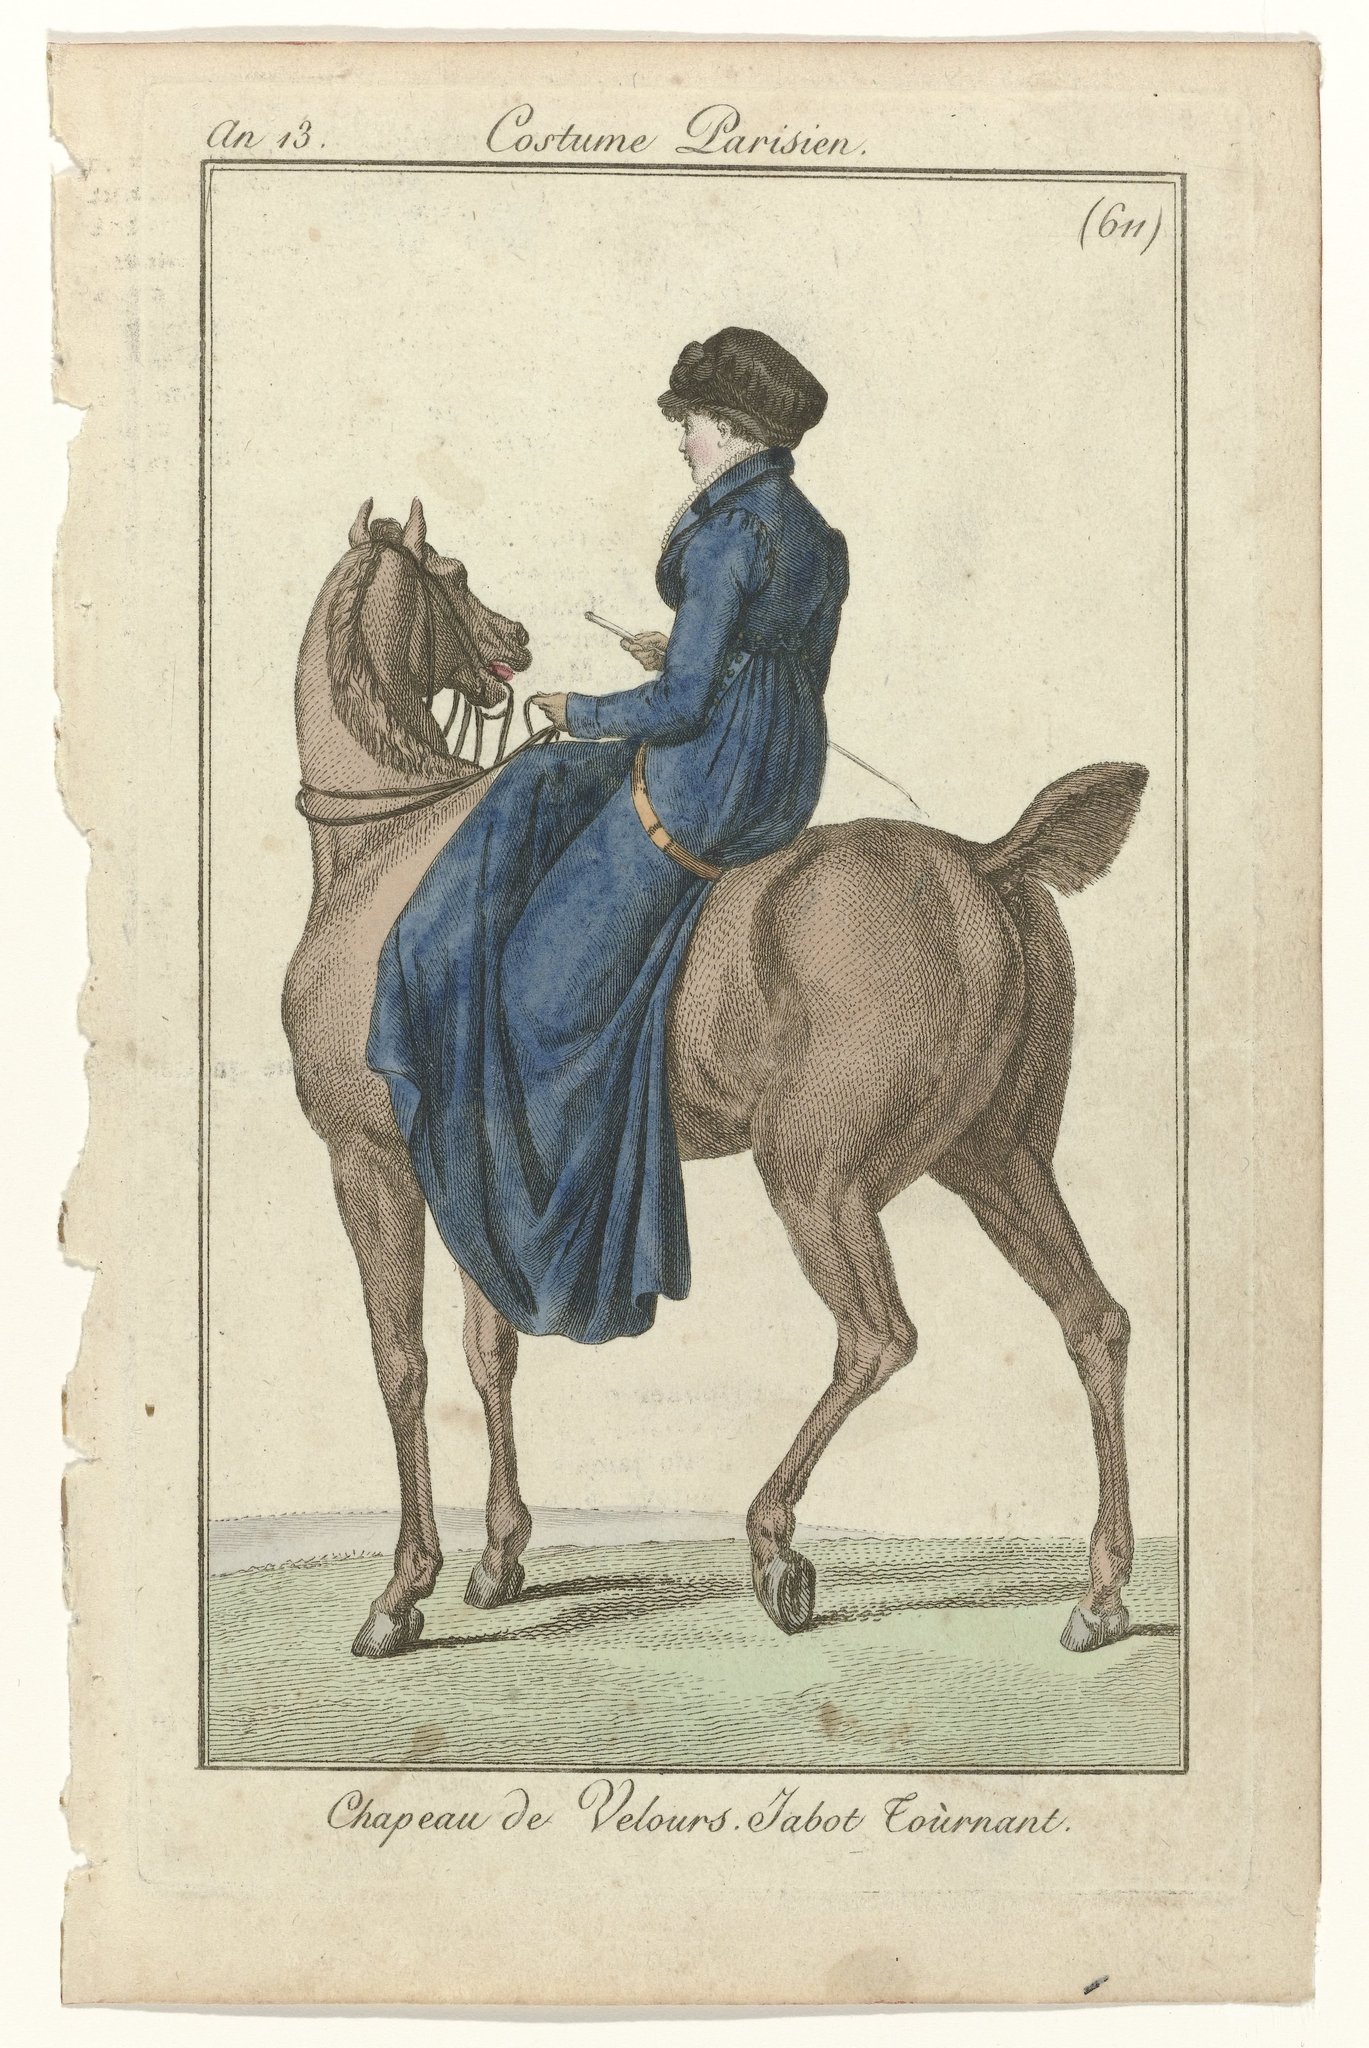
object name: fashion print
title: Journal des Dames et des Modes, Costume Parisien, 15 janv.1805, An 13 (611) : Chapeau de Velours (...)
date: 1805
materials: paper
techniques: engraving, hand coloring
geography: paris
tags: clothing for the upper part of the body (spencer) (+ women's clothes), fashion plates, head-gear: hat (+ women's clothes), gloves, mittens, etc. (+ women's clothes), whip, ensembles of pieces of clothing (riding costume) (+ women's clothes), riding a horse, ass, or mule; rider, horseman (+ sitting on animal with both legs on one side, riding side-saddle)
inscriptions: caption: ‘Chapeau de Velours. Jabot Tournant.’, title: ‘Costume Parisien.’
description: Vrouw in amazonezit te paard Op het hoofd een hoed van fluweel. Amazonekostuum (rijkostuum) met een 'jabot tournant' en gele handschoenen. Een rijzweep in de rechterhand. De prent maakt deel uit van het modetijdschrift Journal des Dames et des Modes, uitgegeven door Pierre de la Mésangère, Parijs, 1797-1839.